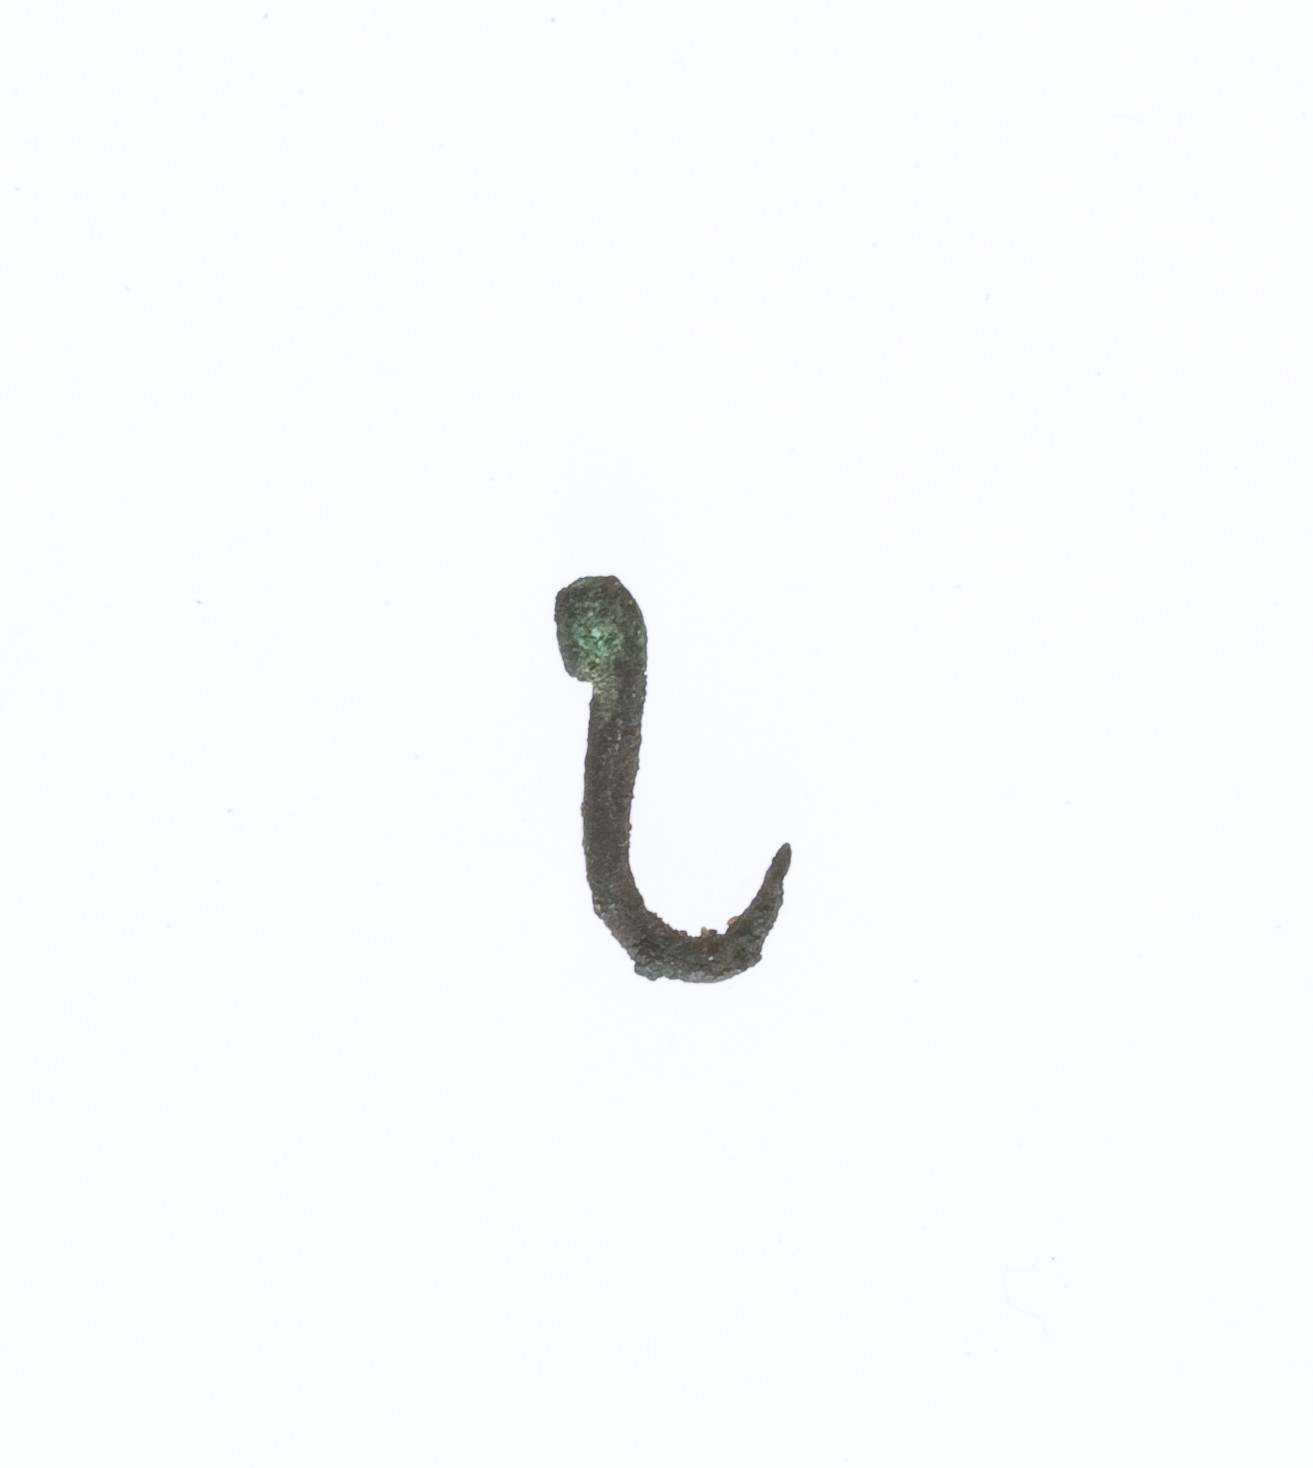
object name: fish hook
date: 1295-1070 BCE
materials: bronze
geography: egypt